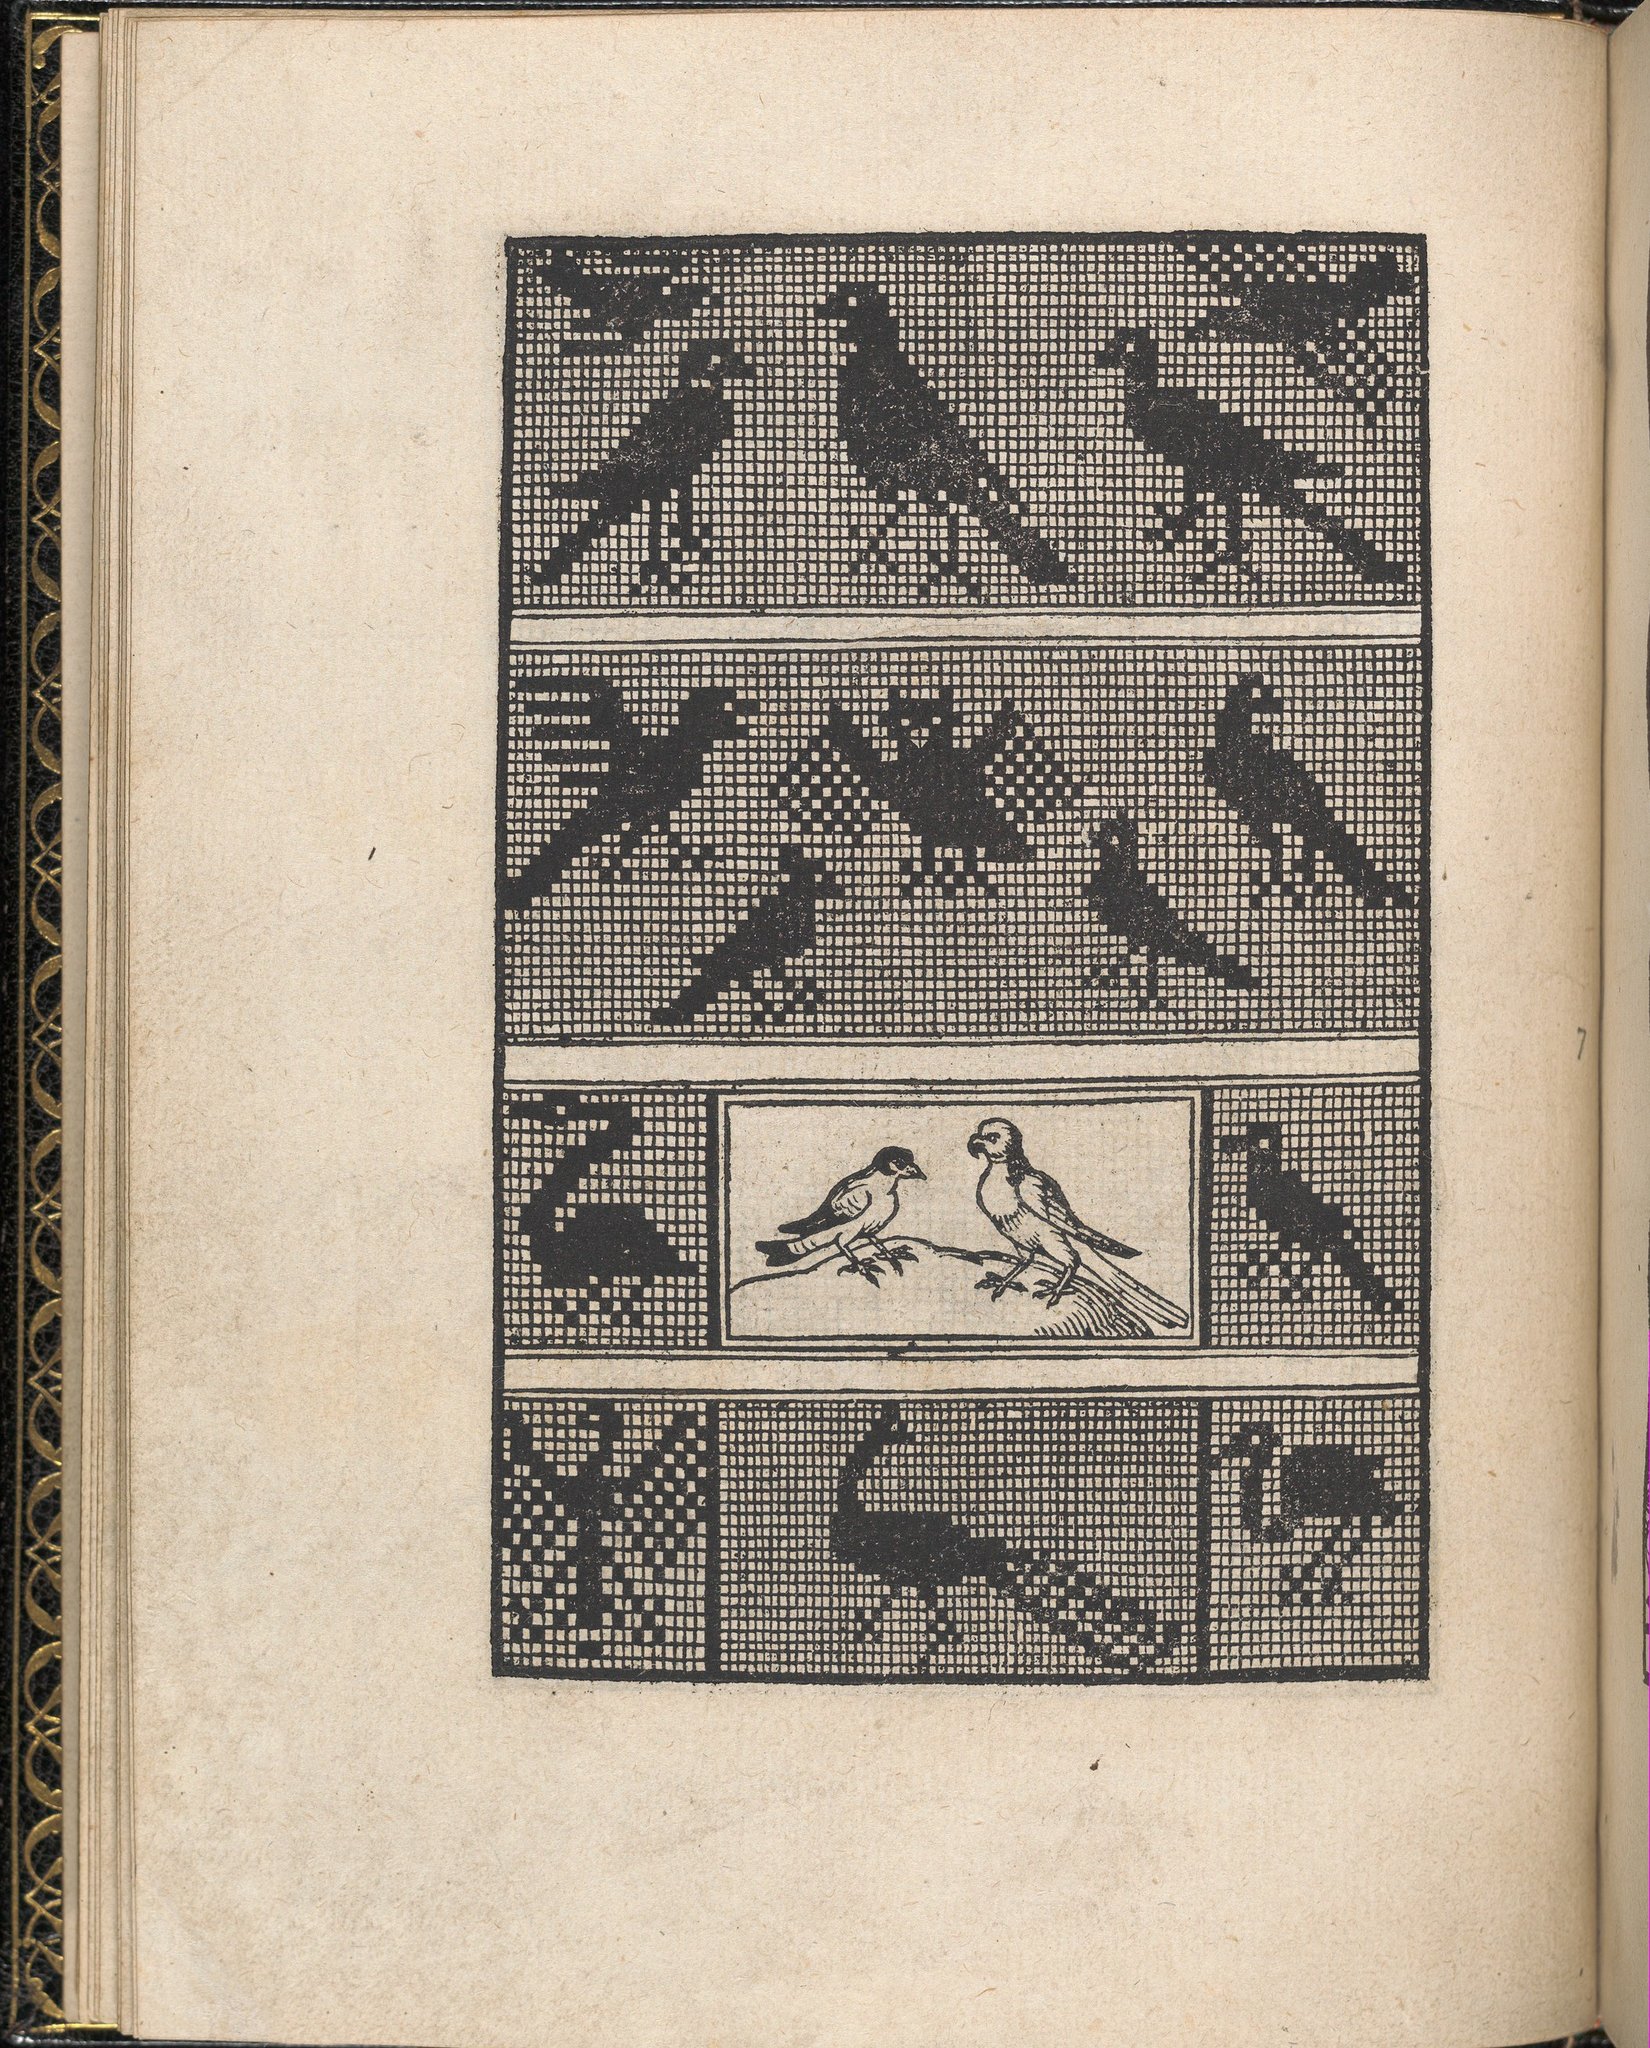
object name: book print ornament architecture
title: Page from Ein new kunstlich Modelbuch...(Page 7v)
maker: peter quentel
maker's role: publisher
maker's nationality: german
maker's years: 1500-1550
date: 1544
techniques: woodcut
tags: birds